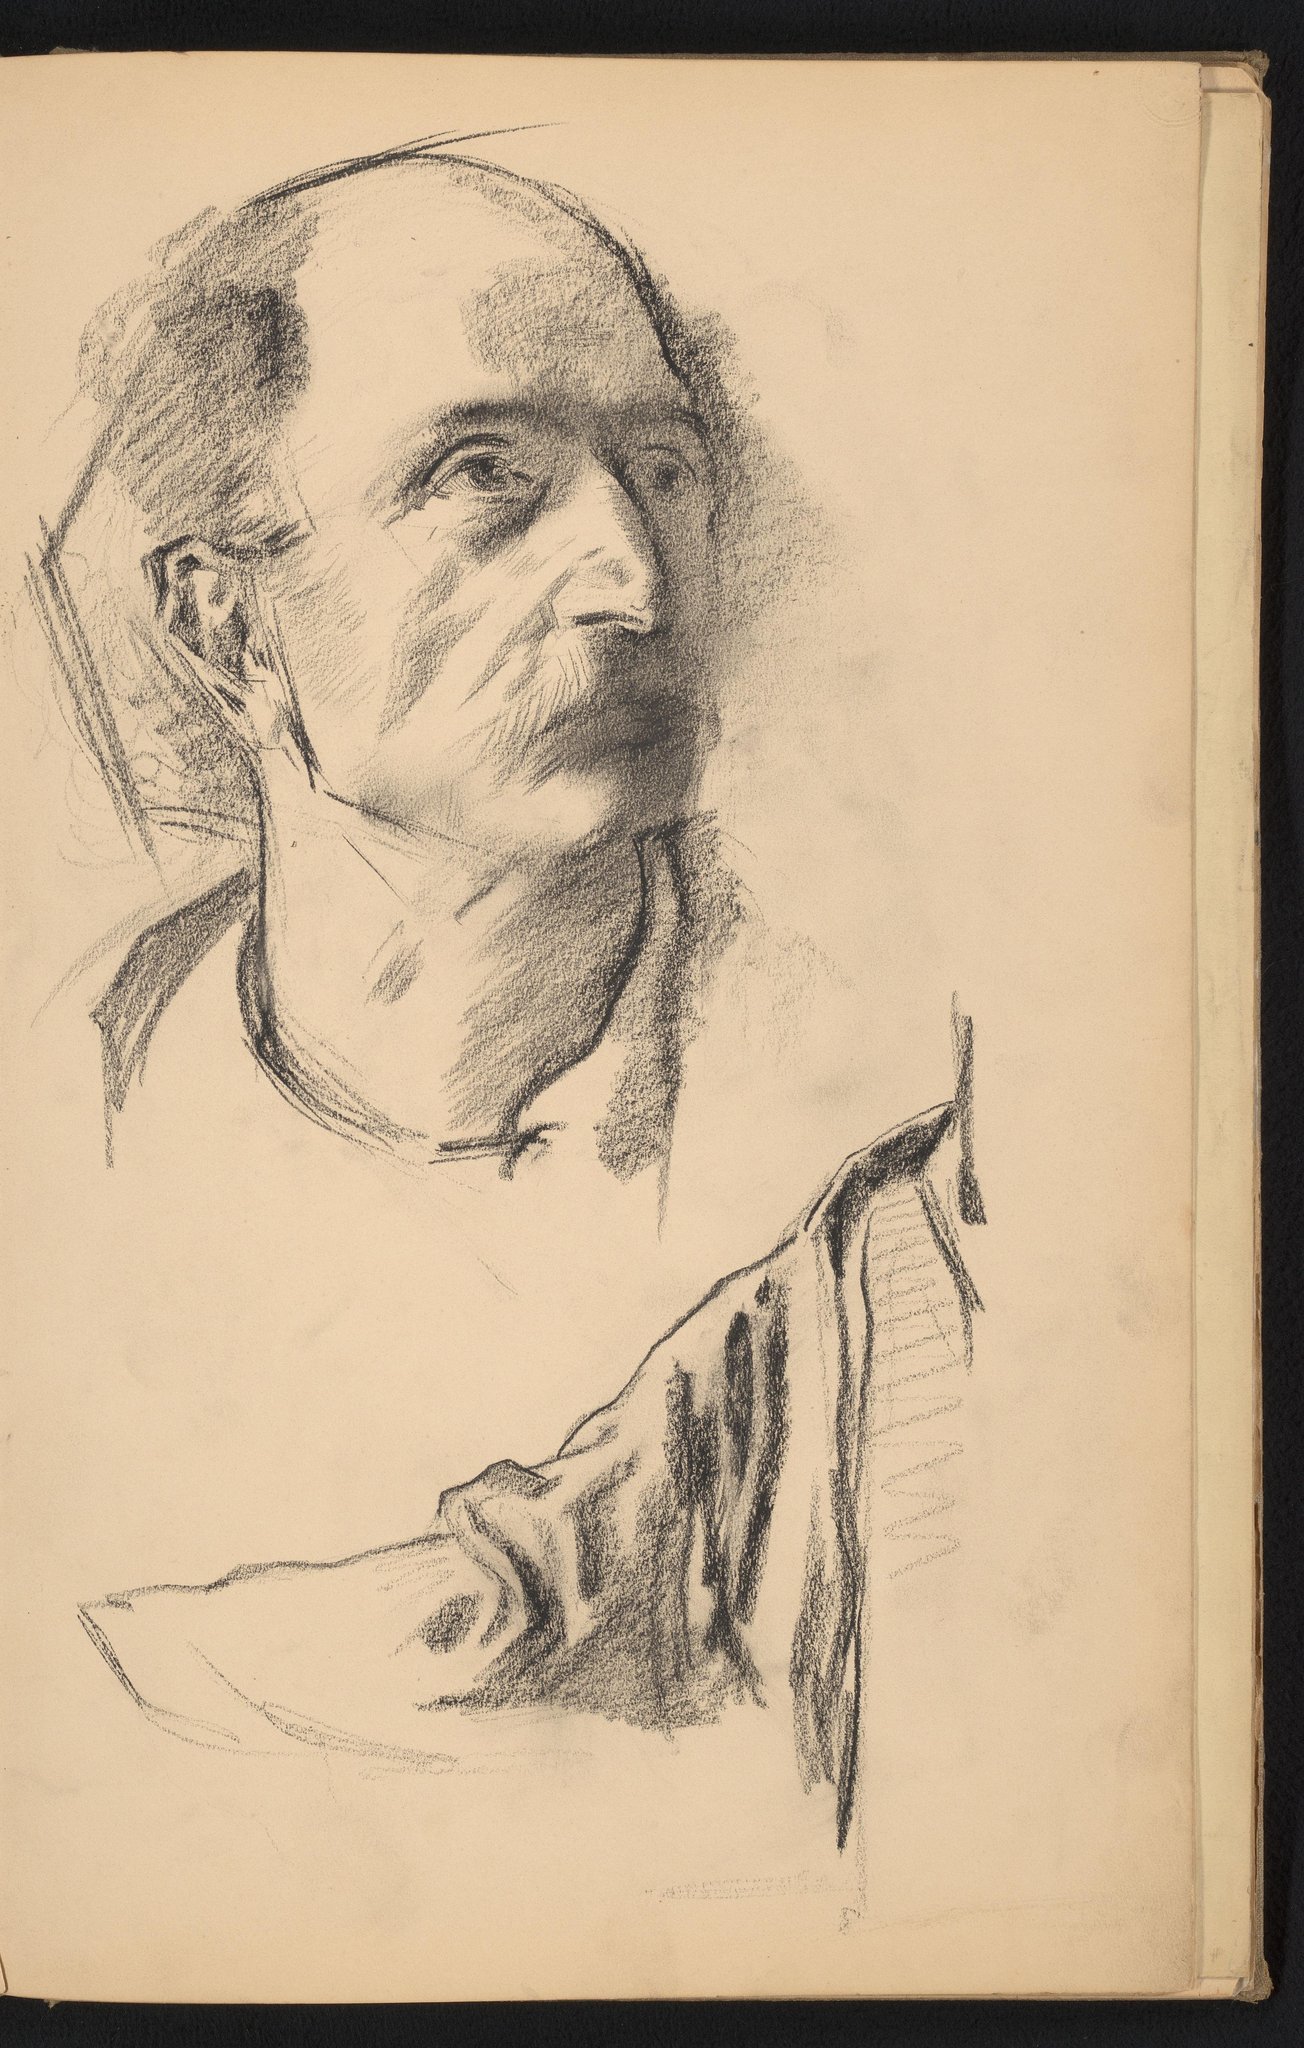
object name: sketchbook leaf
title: Mouw en een portret van een man met een snor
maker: huib luns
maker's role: draughtsman, print maker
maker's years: 1881-1942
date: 1908-1909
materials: chalk, paper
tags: sleeves, anonymous historical person portrayed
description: Blad 16 verso uit een schetsboek met 24 bladen.